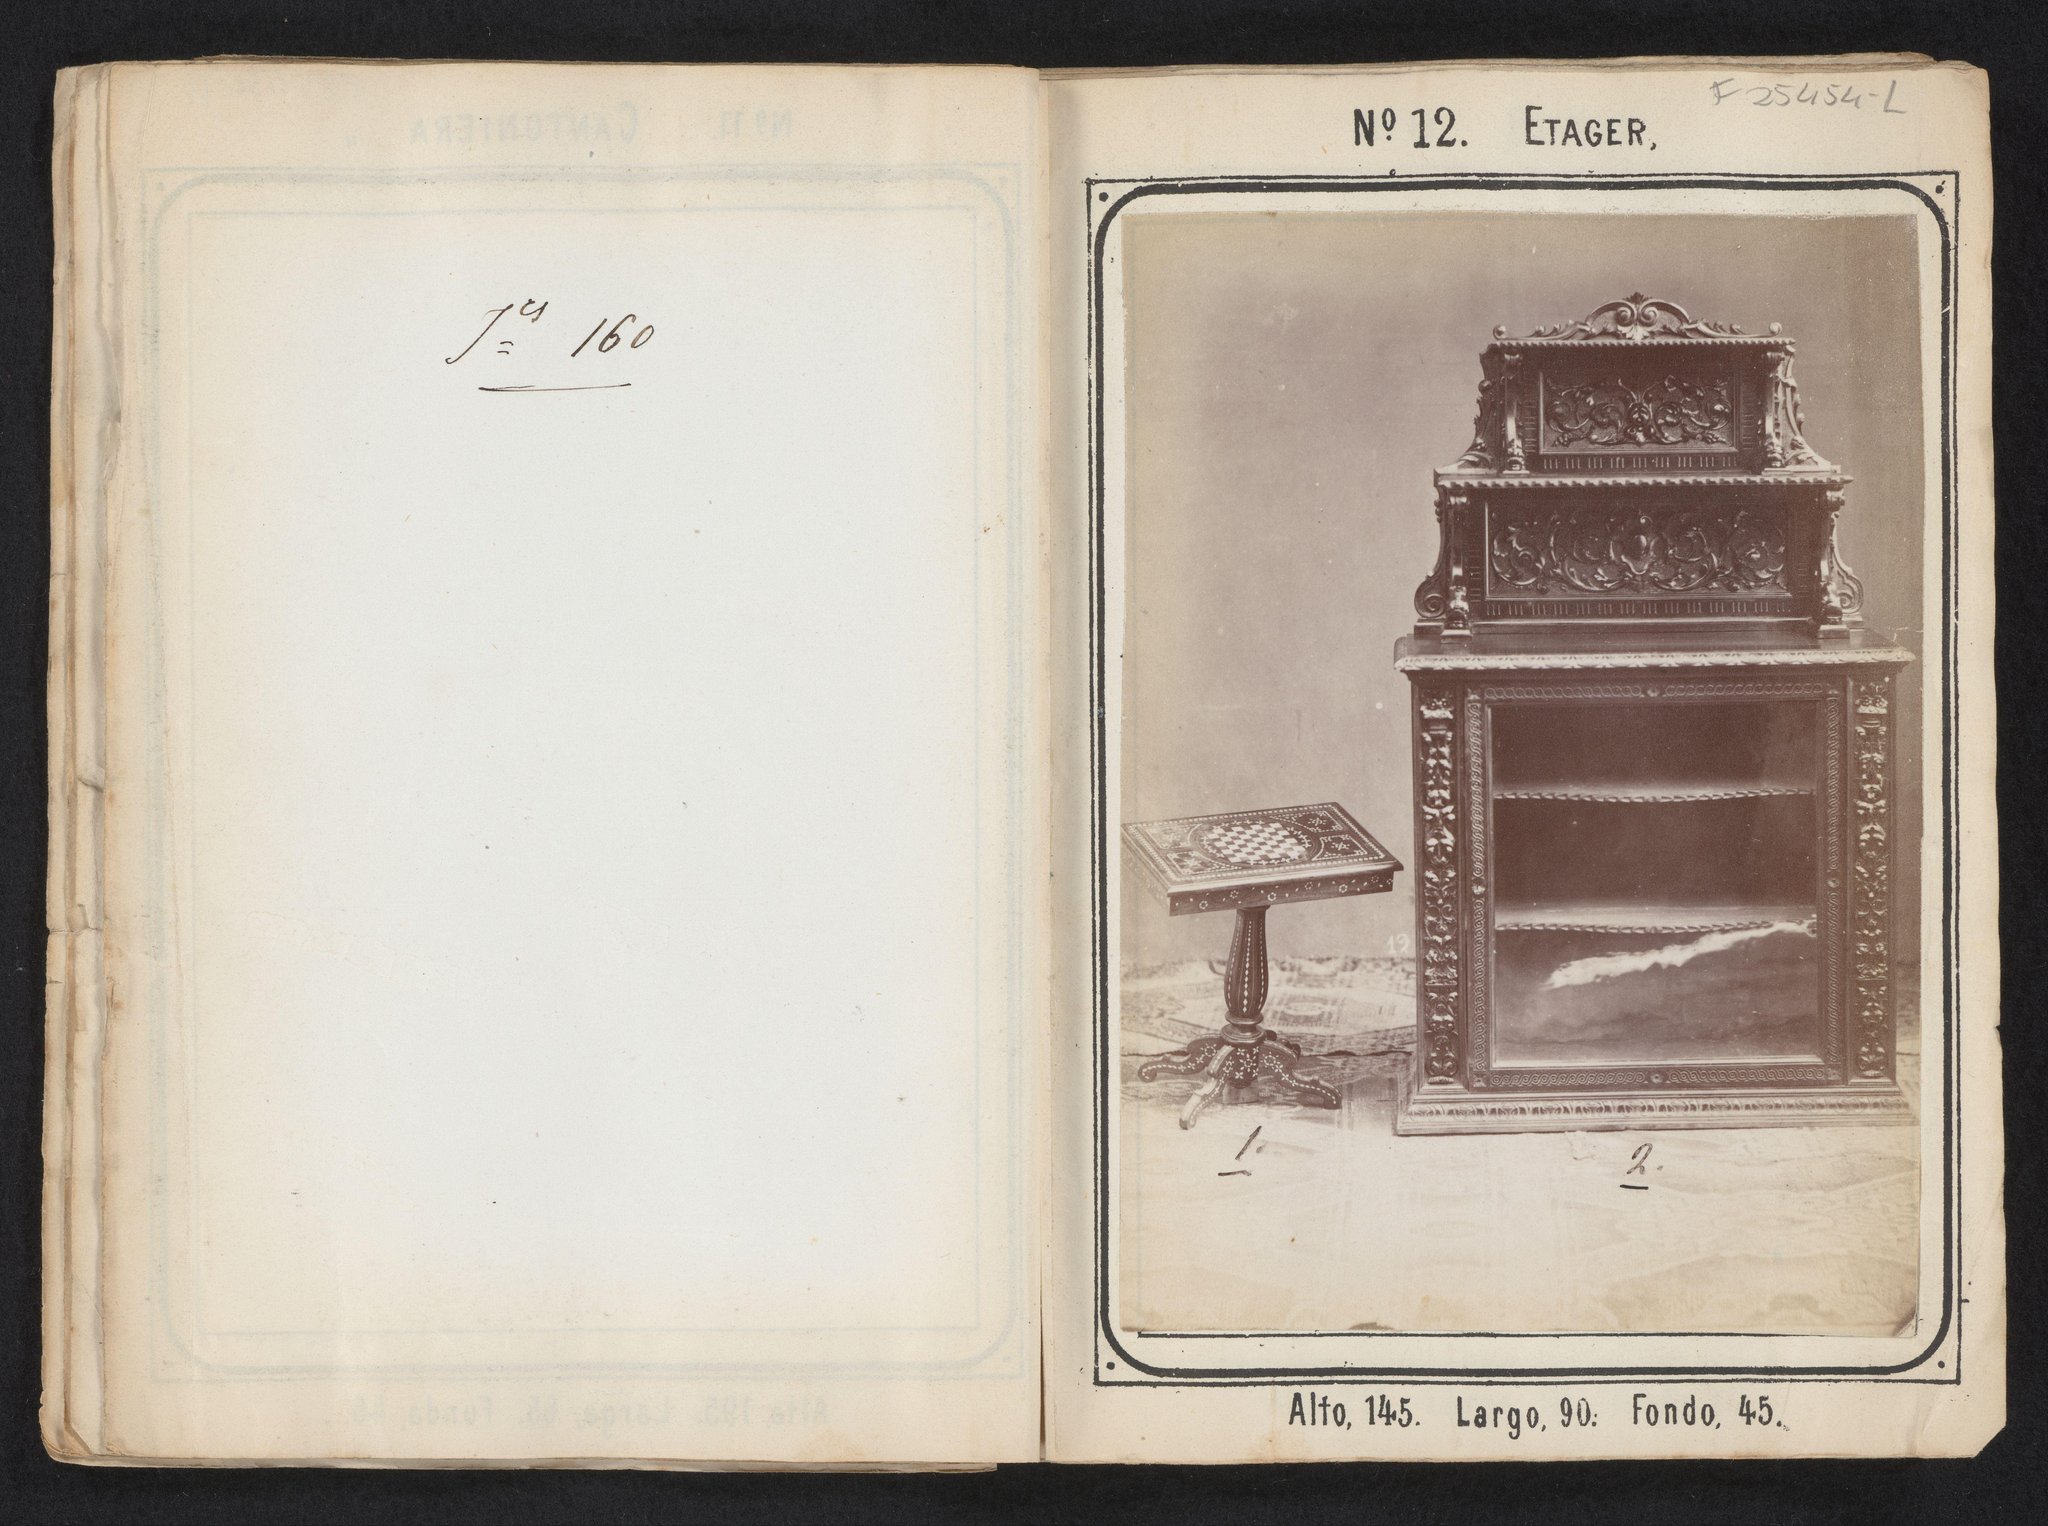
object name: page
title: No 12 Etager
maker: Anonymous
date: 1878-1885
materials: paper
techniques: albumen print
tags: table, cupboard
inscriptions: inscription: ‘1. 2.’, inscription: ‘No 1. Ies. 40/ " 2 "170.’, inscription: ‘Alto, 145. Largo, 90. Fondo, 45.’